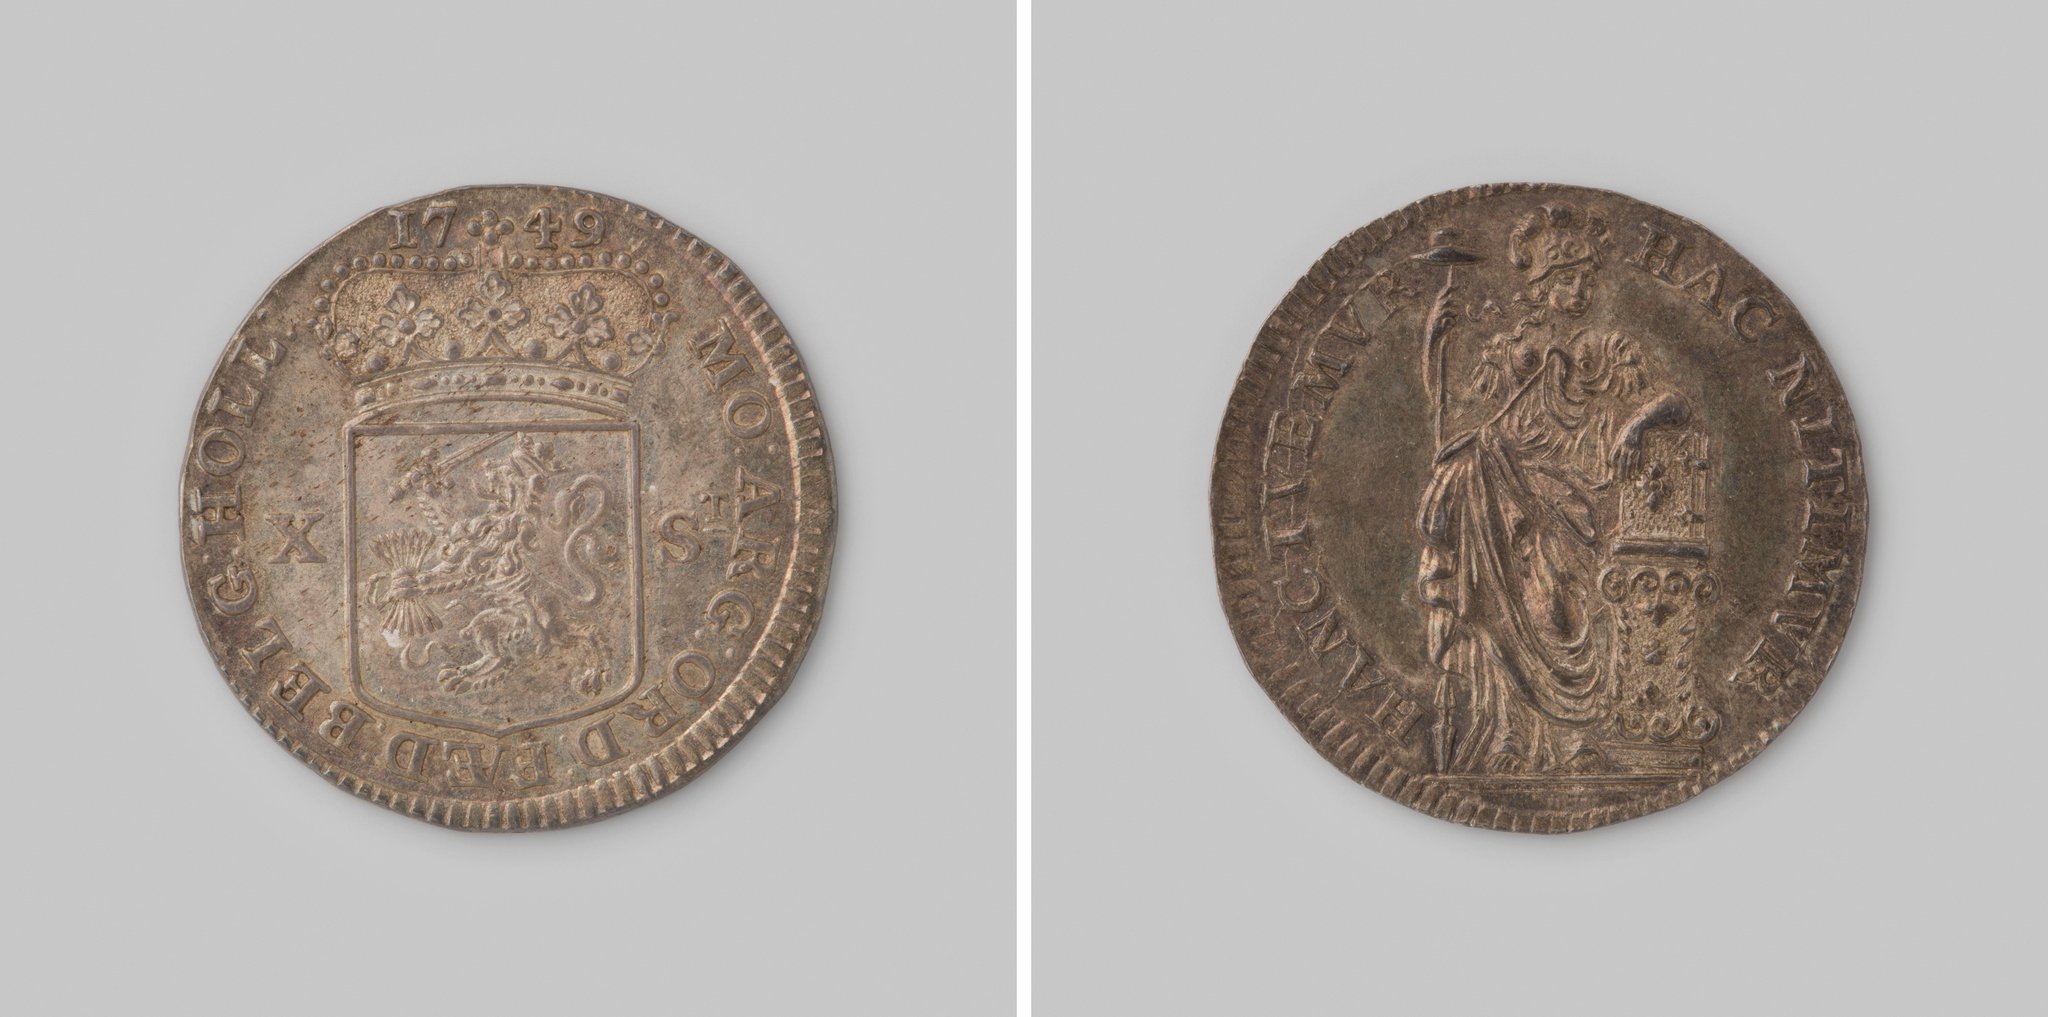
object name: halve gulden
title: Holland, halve gulden, 1749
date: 1749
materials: silver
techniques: striking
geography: dordrecht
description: Zilveren munt. Voorzijde: tussen waarde-aanduiding X St gekroond generaliteitswapenschild. Jaartal boven kroon. Keerzijde: staande Nederlandse maagd met in rechterhand speer, waarop hoed en met linkerhand steunend op altaar, waarop bijbel.